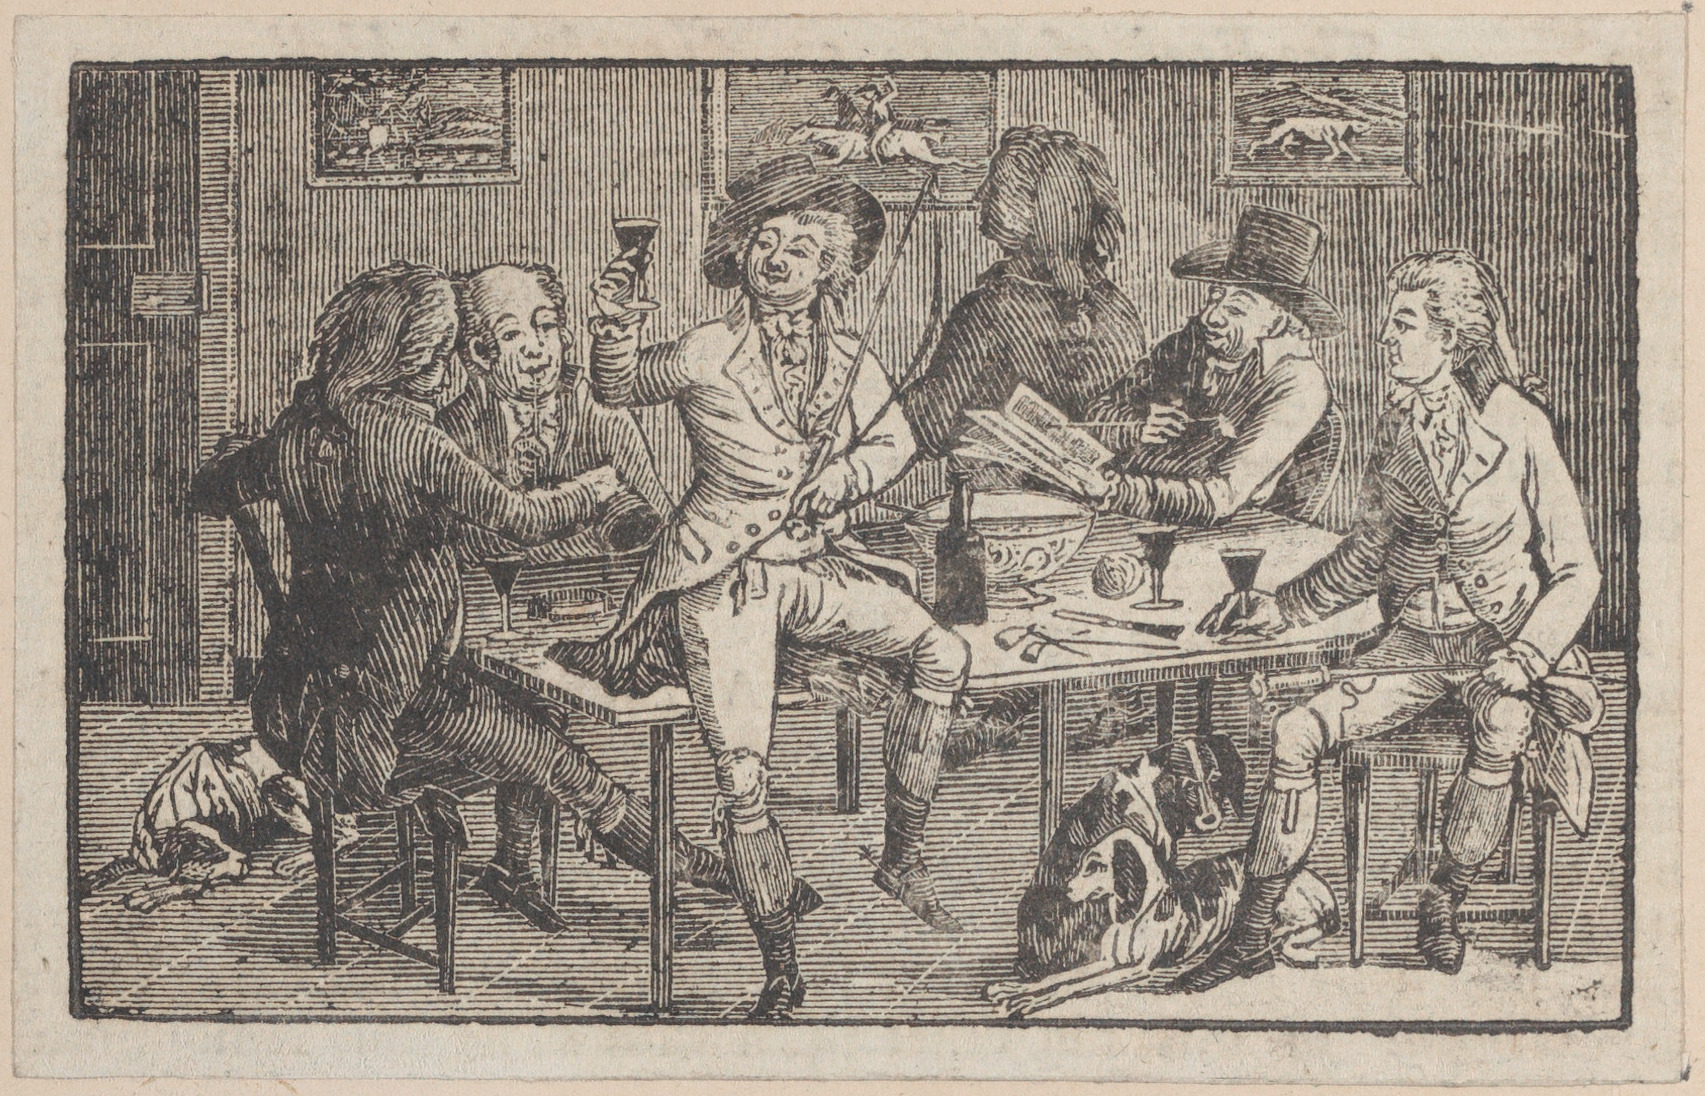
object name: print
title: Men seated around a punch bowl, with a hunter offering a toast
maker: thomas bewick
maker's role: engraver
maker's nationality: british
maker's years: 1753-1828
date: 1790-1828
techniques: engraving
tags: satire,men,dogs,drinking